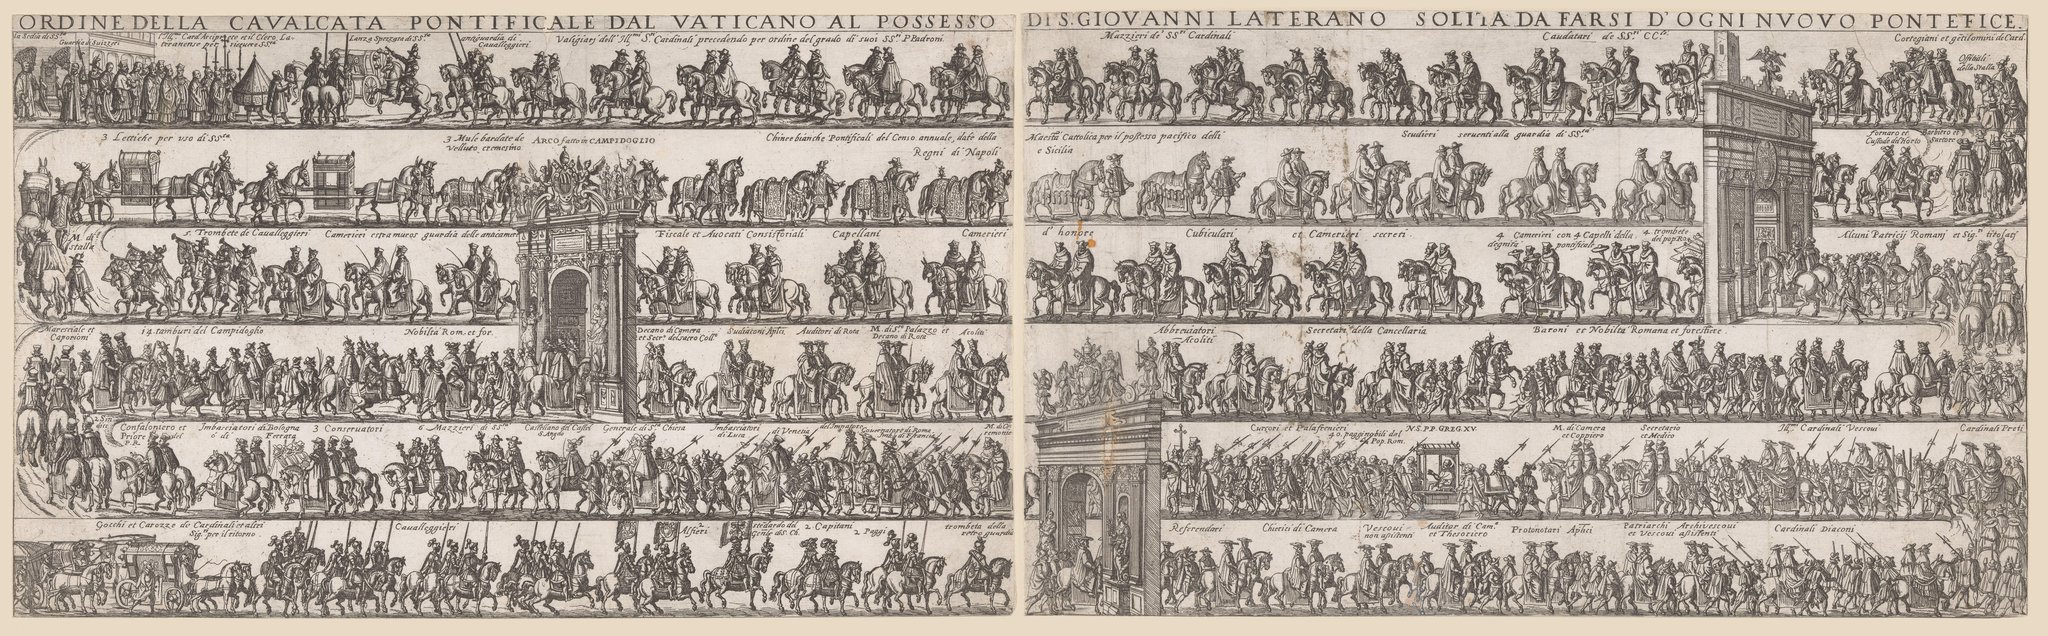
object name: print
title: Pauselijke processie met Gregorius XV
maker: Anonymous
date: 1621-1623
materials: paper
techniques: etching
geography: italy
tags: gregorius xv, papal coronation procession, city-gate, rome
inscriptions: collector's mark: Lugt 240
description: Pauselijke processie (cavalcata papale) van de Sint-Pietersbasiliek in het Vaticaan naar de Sint-Jan van Lateranen in Rome, die gewoonlijk werd afgelegd na de kroning van een nieuwe paus. De processie loopt over zes horizontale banen, waarbij de figuren drie keer een poort passeren.